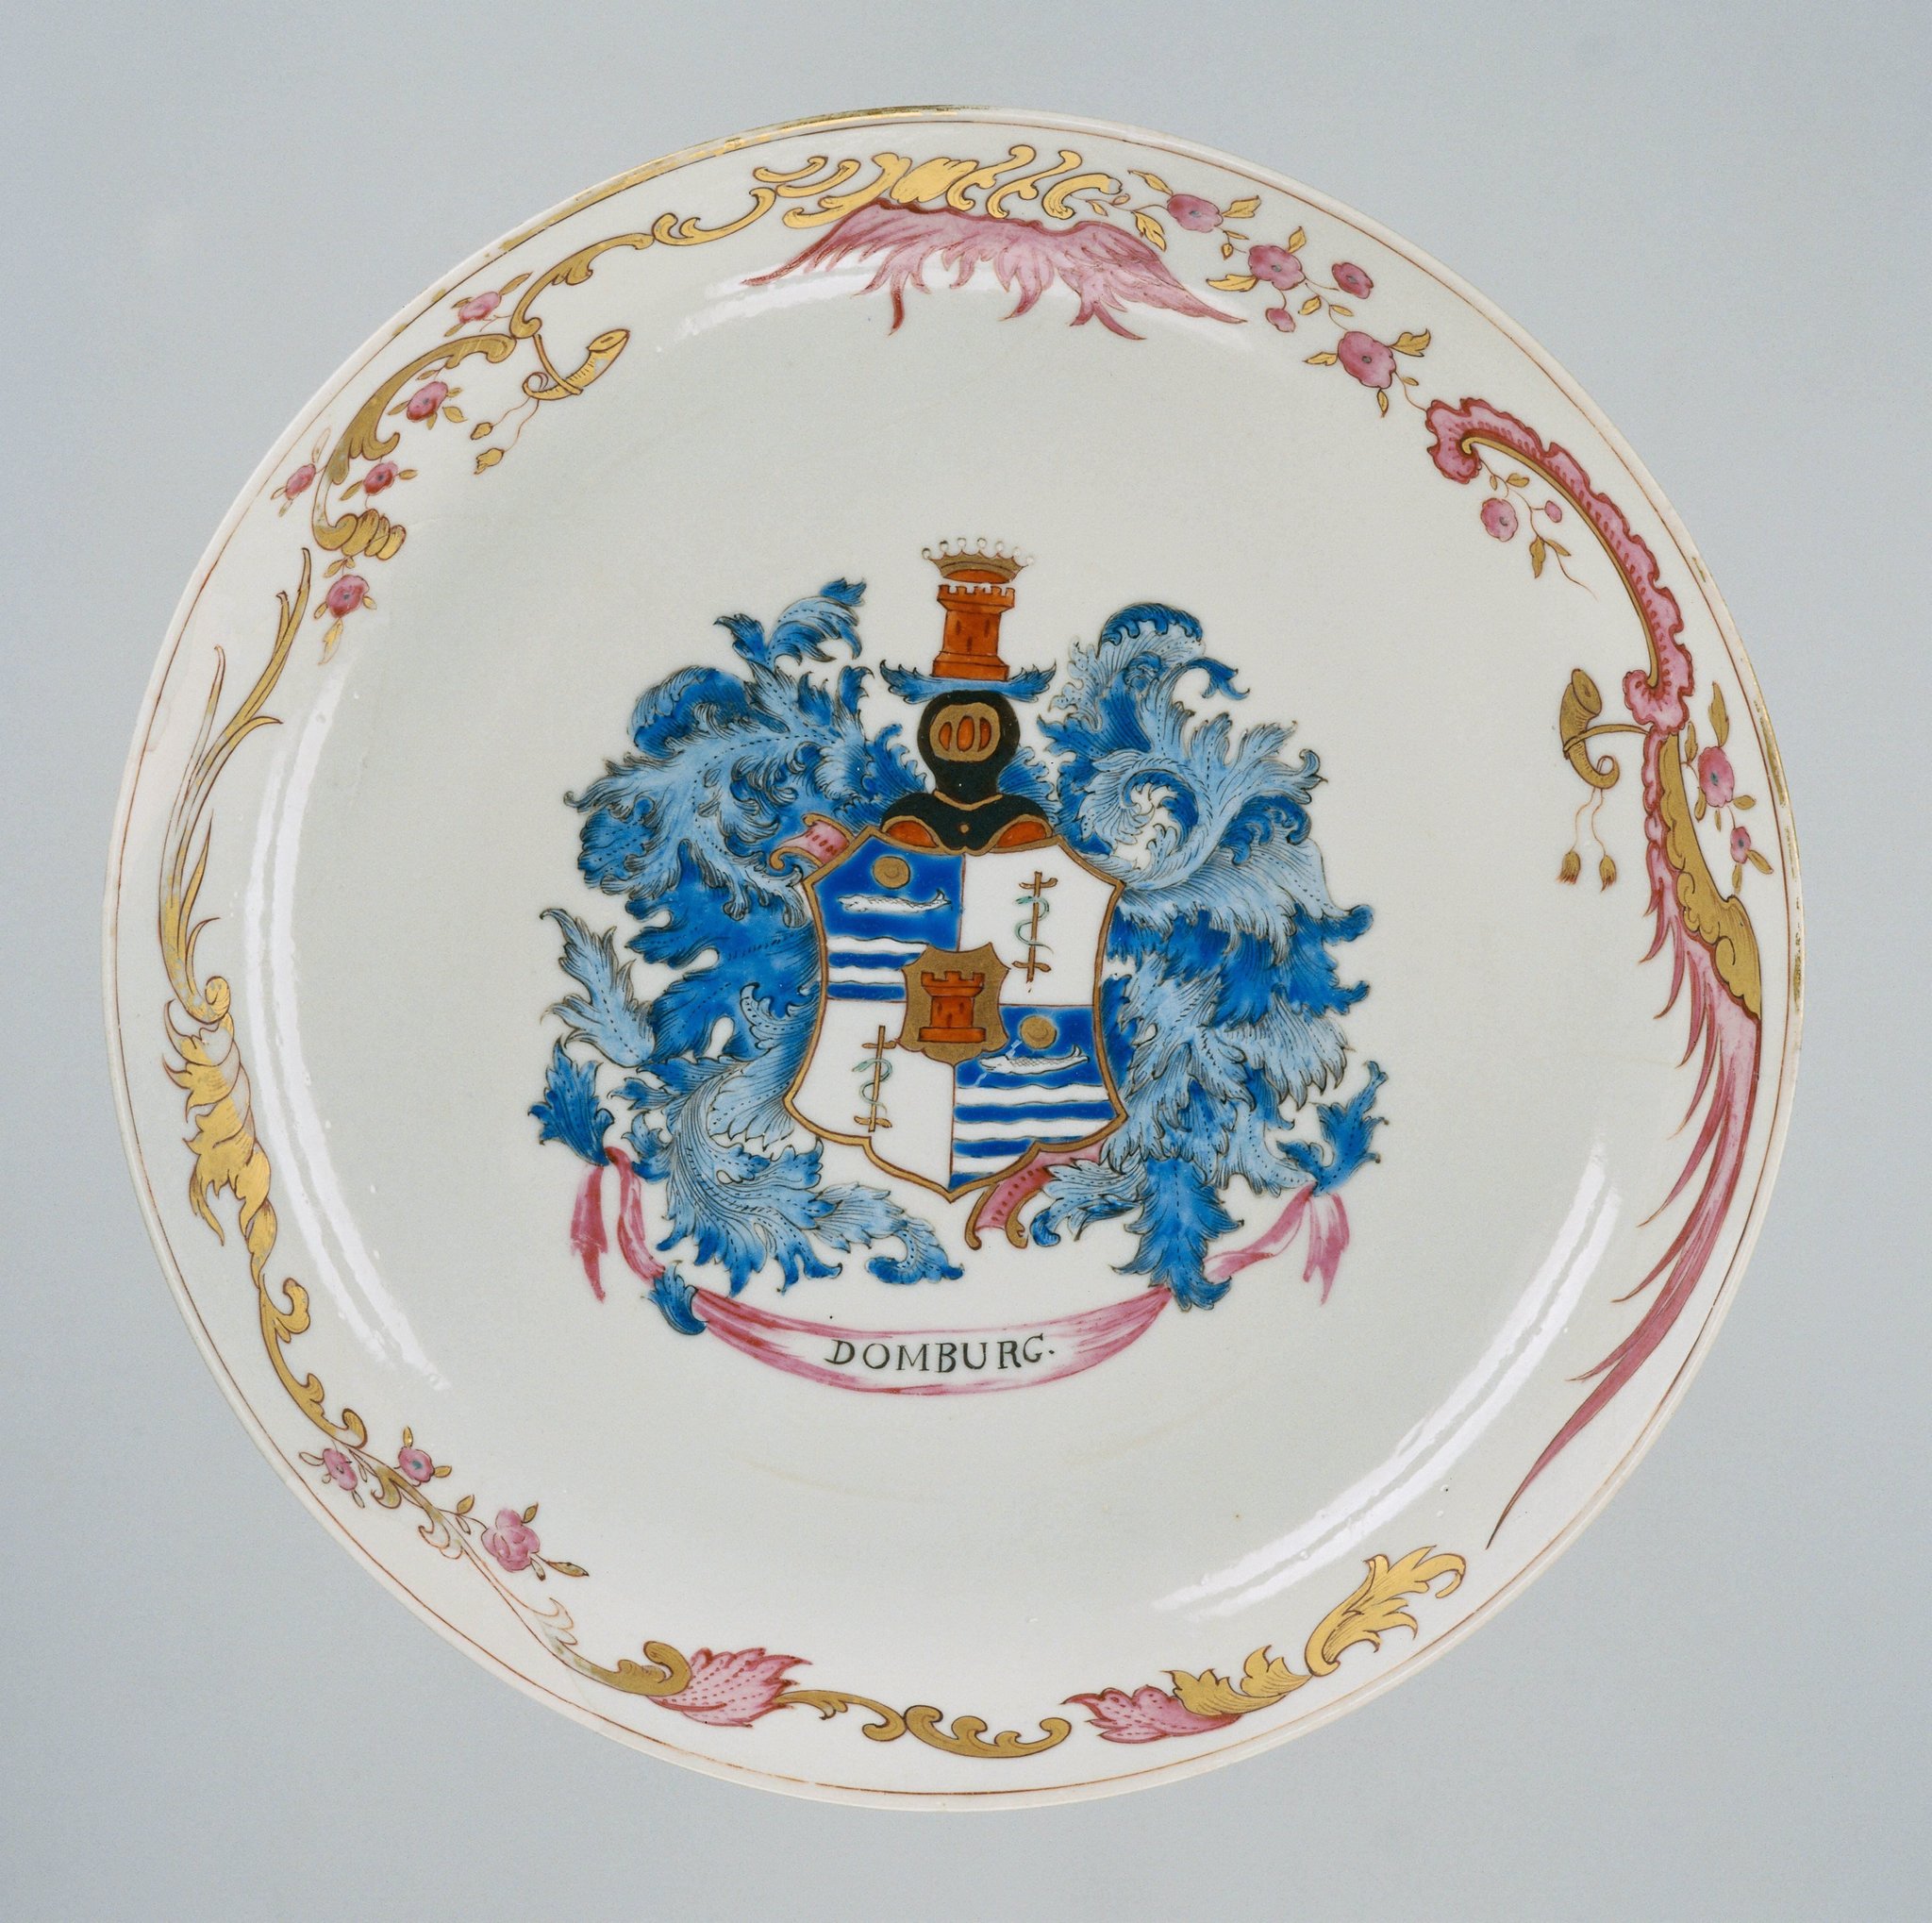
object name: dish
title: Plate with the Domburg family coat of arms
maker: Anonymous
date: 1750-1758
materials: glaze, gold, paint, porcelain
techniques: firing, gilding, turning, vitrification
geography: china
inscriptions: inscription: ‘DOMBURG.’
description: Albertus Domburg of Amsterdam worked for the VOC in Asia. He was a notary in Batavia from 1747 to 1757. He likely ordered an armorial porcelain service in Canton in this period.